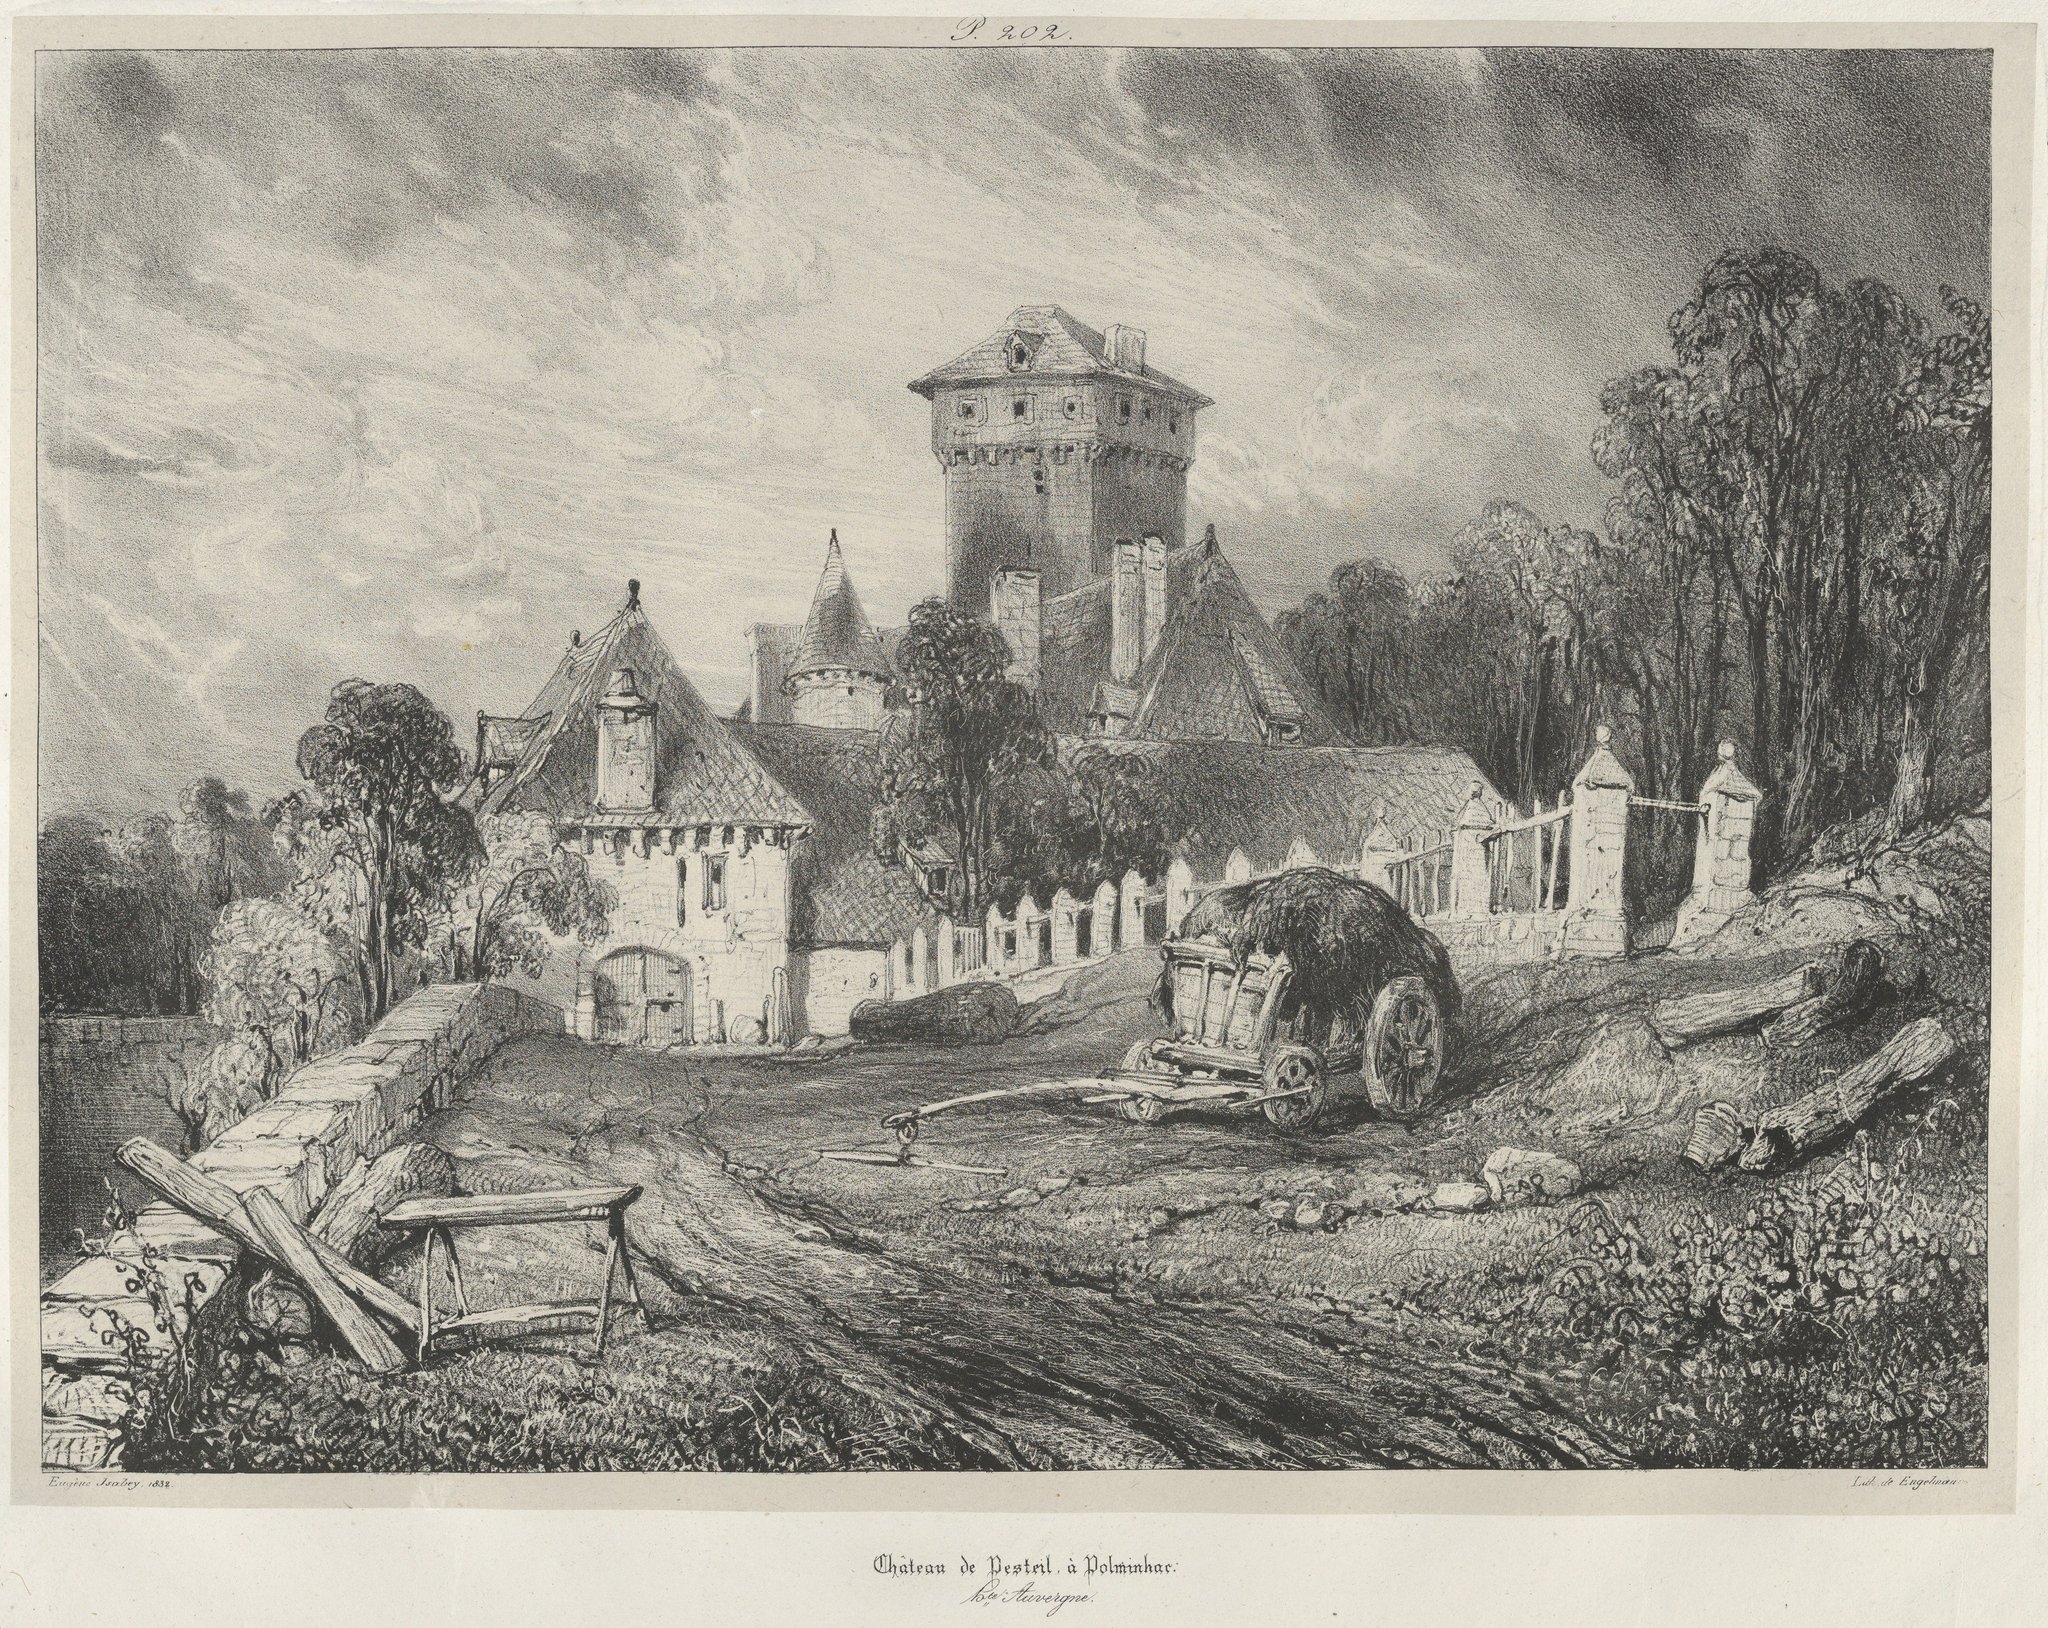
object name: print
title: Pesteil Castle in Polminhac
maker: eugène isabey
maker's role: artist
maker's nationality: french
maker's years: 1803-1886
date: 1832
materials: paper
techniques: printmaking, lithograph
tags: castles